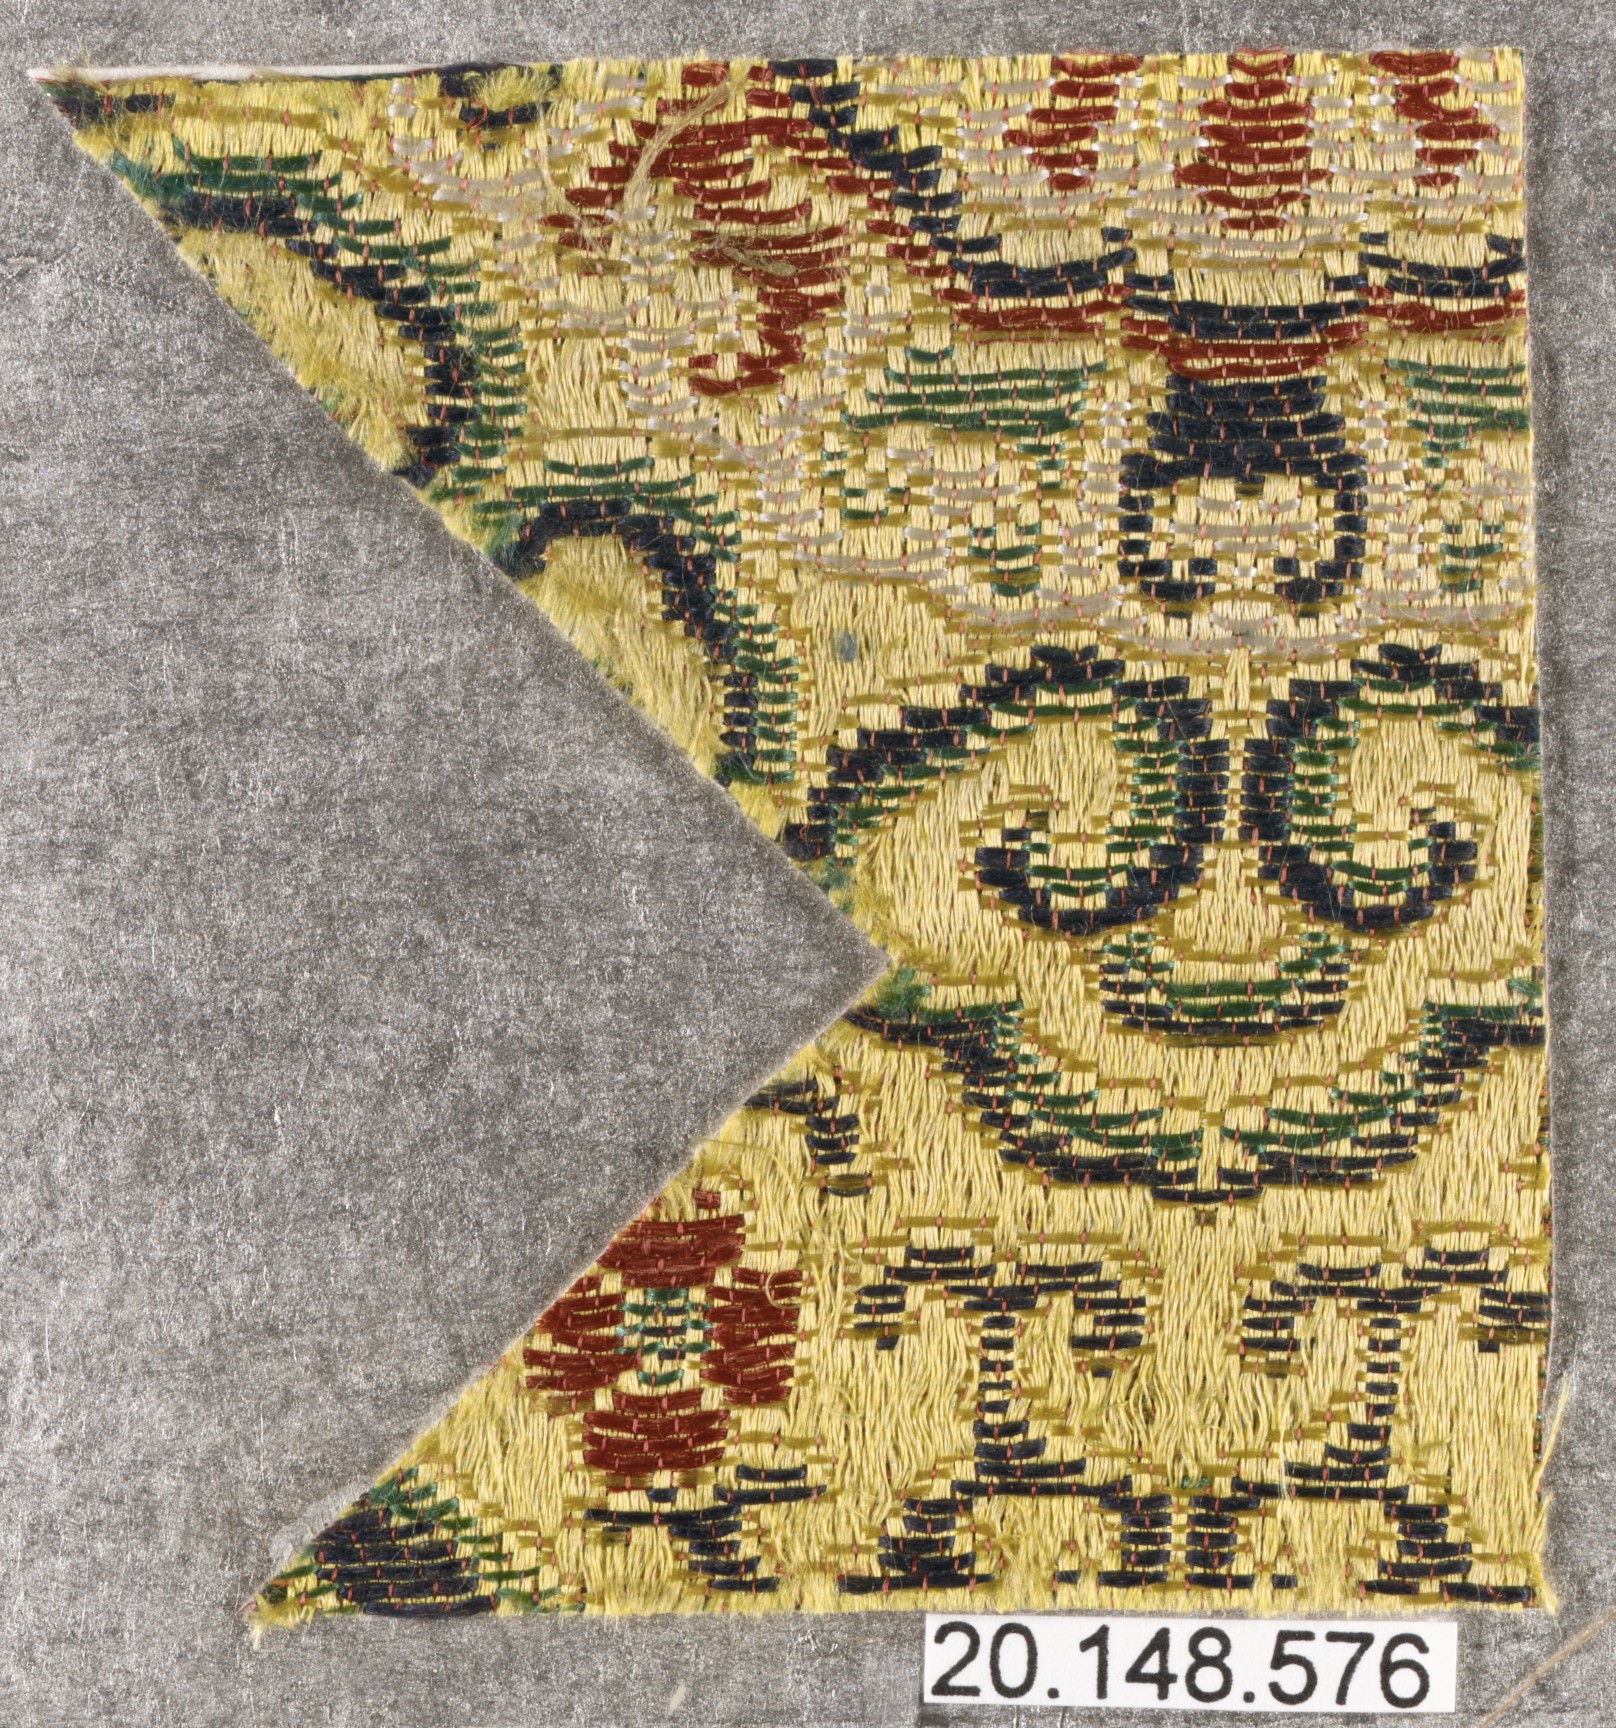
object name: piece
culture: japanese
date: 1701-1800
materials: silk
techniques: compound weave